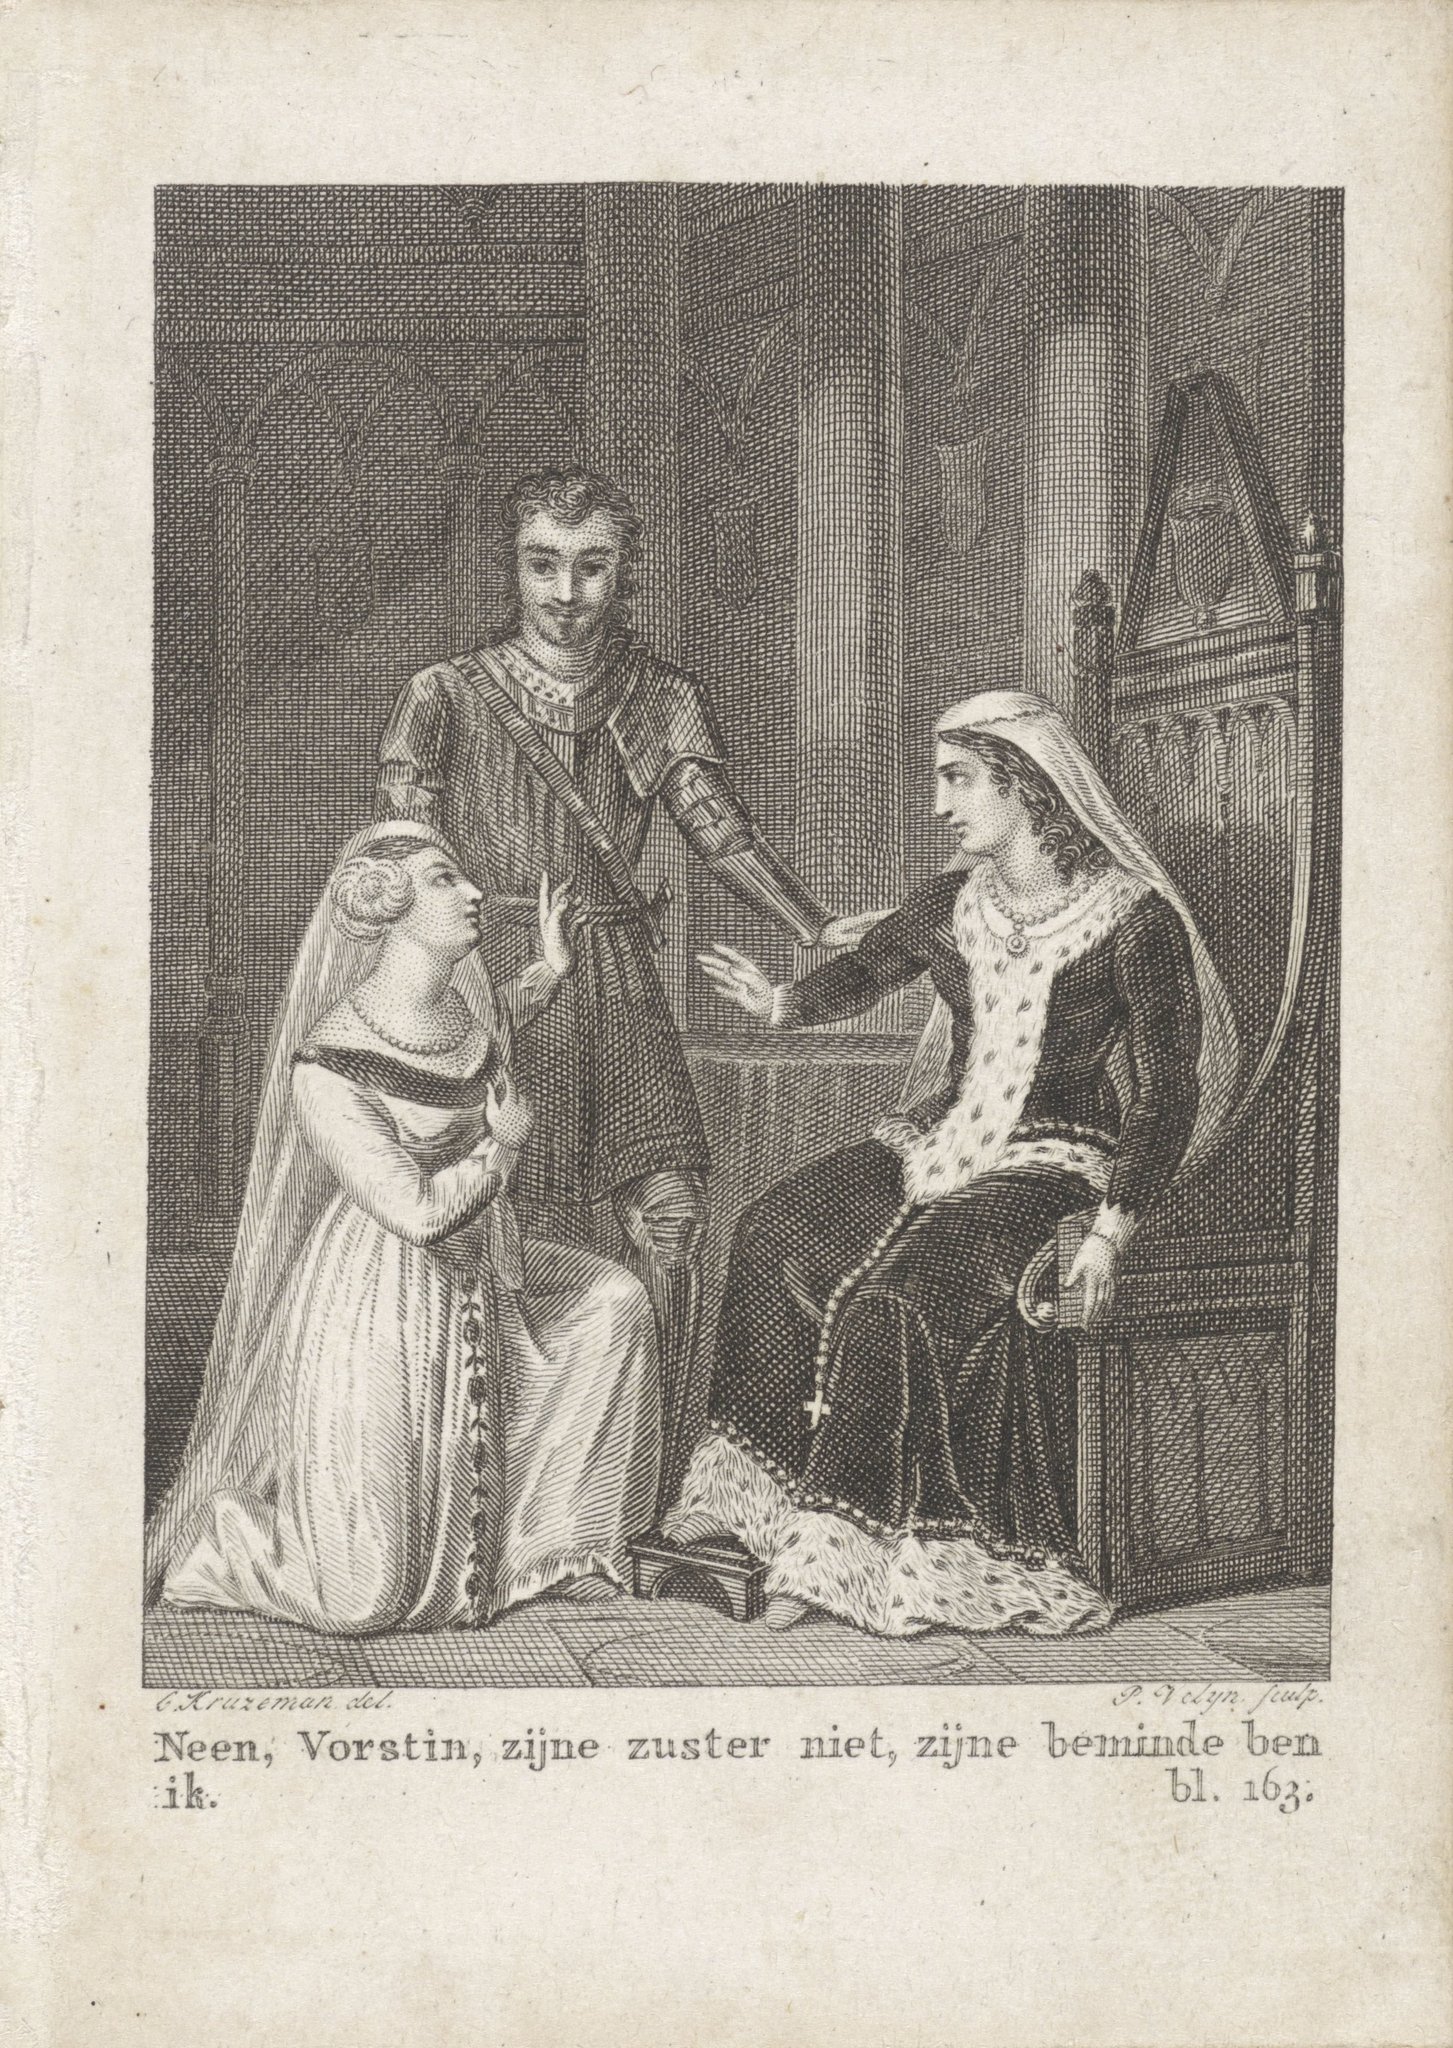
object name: book illustration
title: Paar bij een vrouw op een troon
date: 1822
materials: paper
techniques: etching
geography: netherlands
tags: kneeling figure - aa - female human figure, throne - bb - female ruler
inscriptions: collector's mark: Lugt 2228, inscription: ‘Ridder Occo’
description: Op een troon zit een vrouw met een met hermelijn omzoomde japon, haar hand steekt ze voor haar uit. Voor haar knielt een vrouw die wijst op een man die naast haar staat. Rechtsonder: bl. 163.